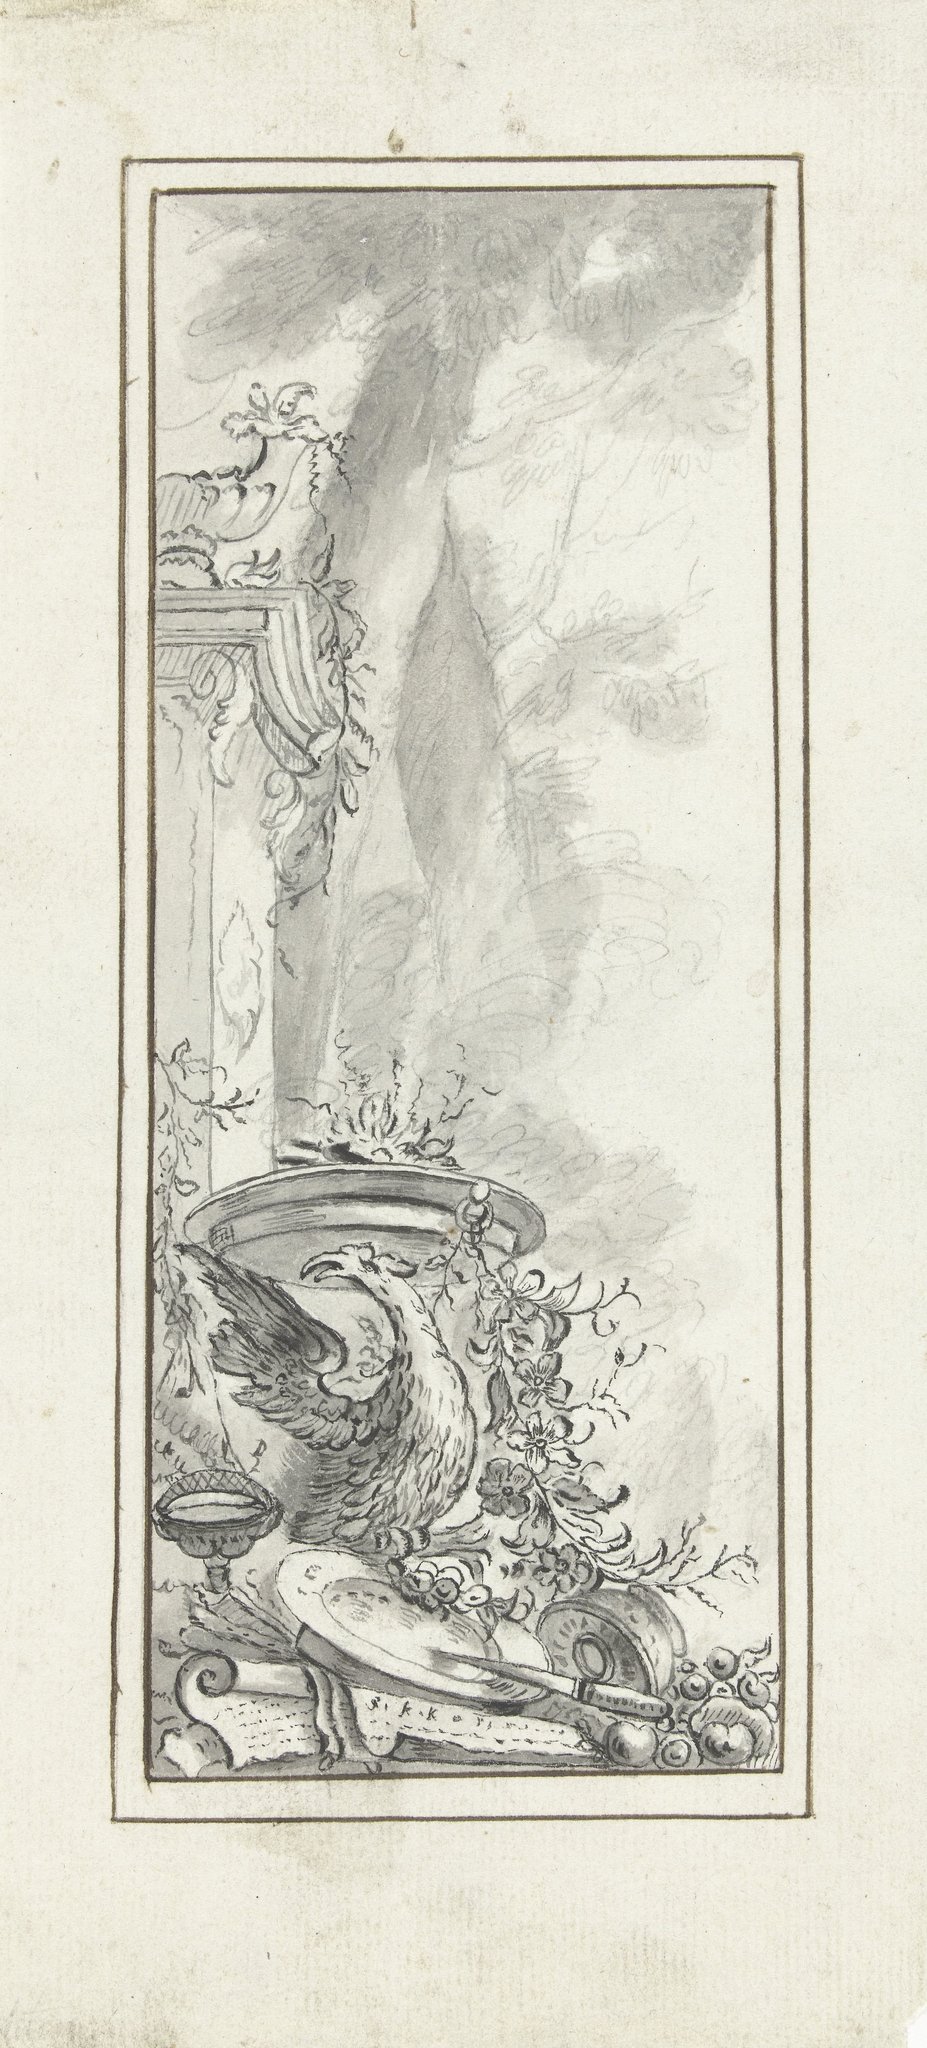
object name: design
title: Ontwerp voor een kamerversiering: een paneel met attributen van Jupiter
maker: abraham meertens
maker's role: draughtsman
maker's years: 1757-1823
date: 1767-1823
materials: ink, paper, pencil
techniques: brush, pen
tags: (other) ornaments derived from objects, attributes of jupiter